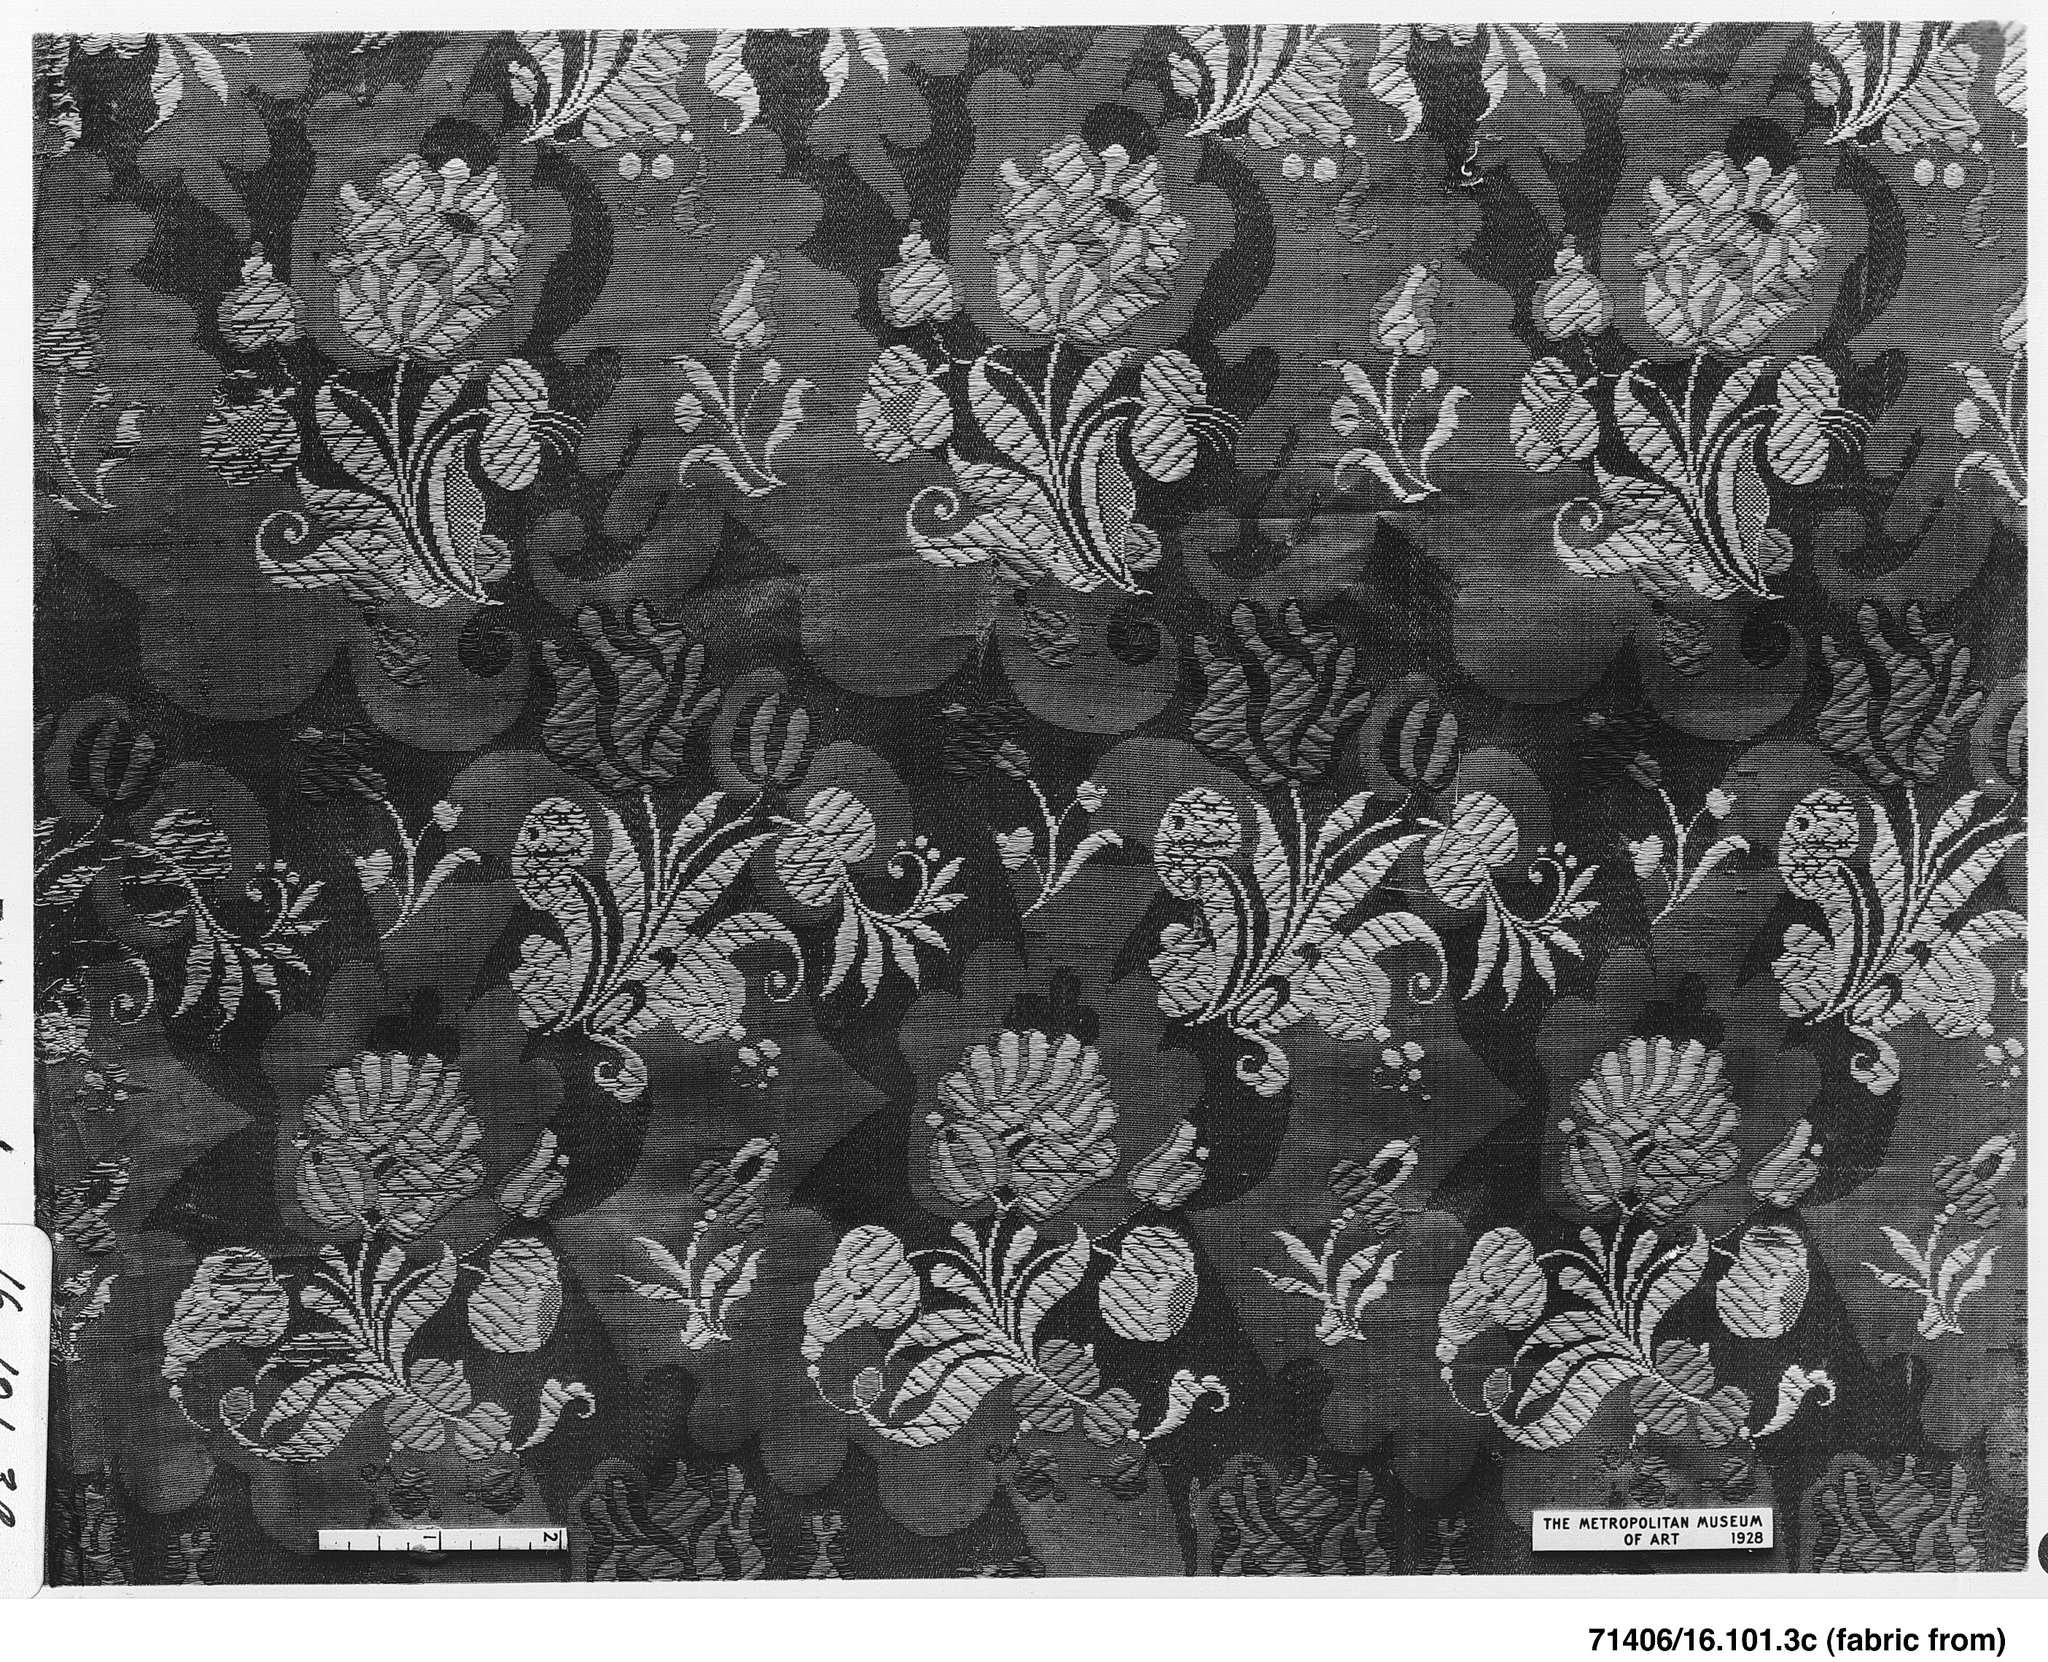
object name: piece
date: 1650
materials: silk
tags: flowers,leaves